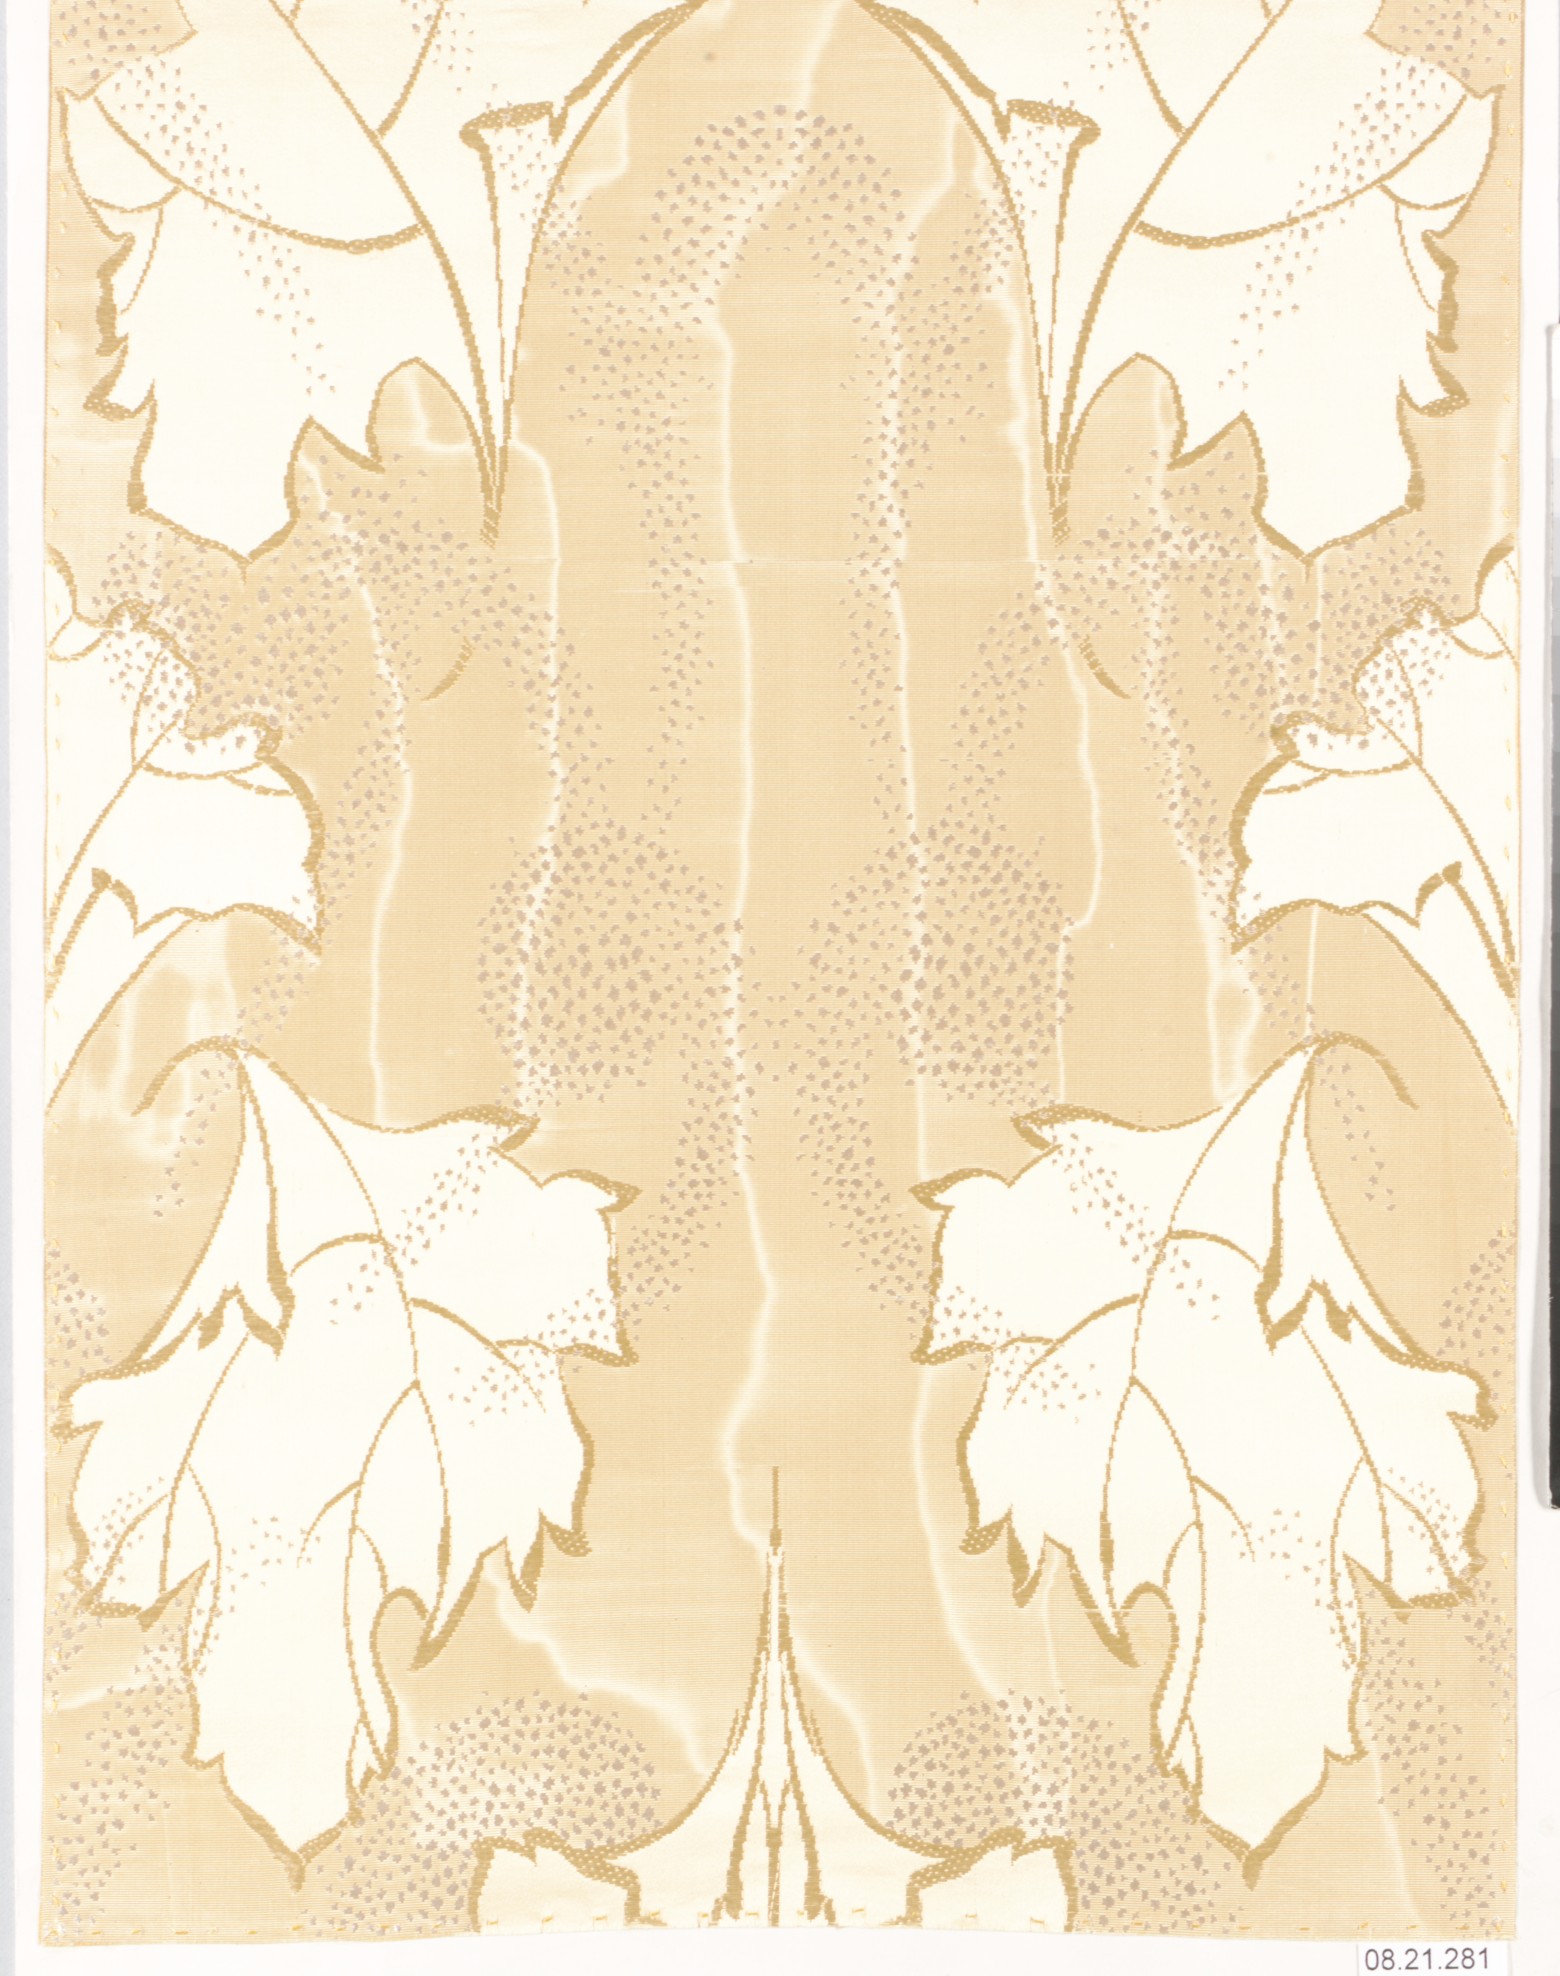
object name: textile sample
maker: Anonymous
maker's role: designer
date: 1900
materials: silk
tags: leaves